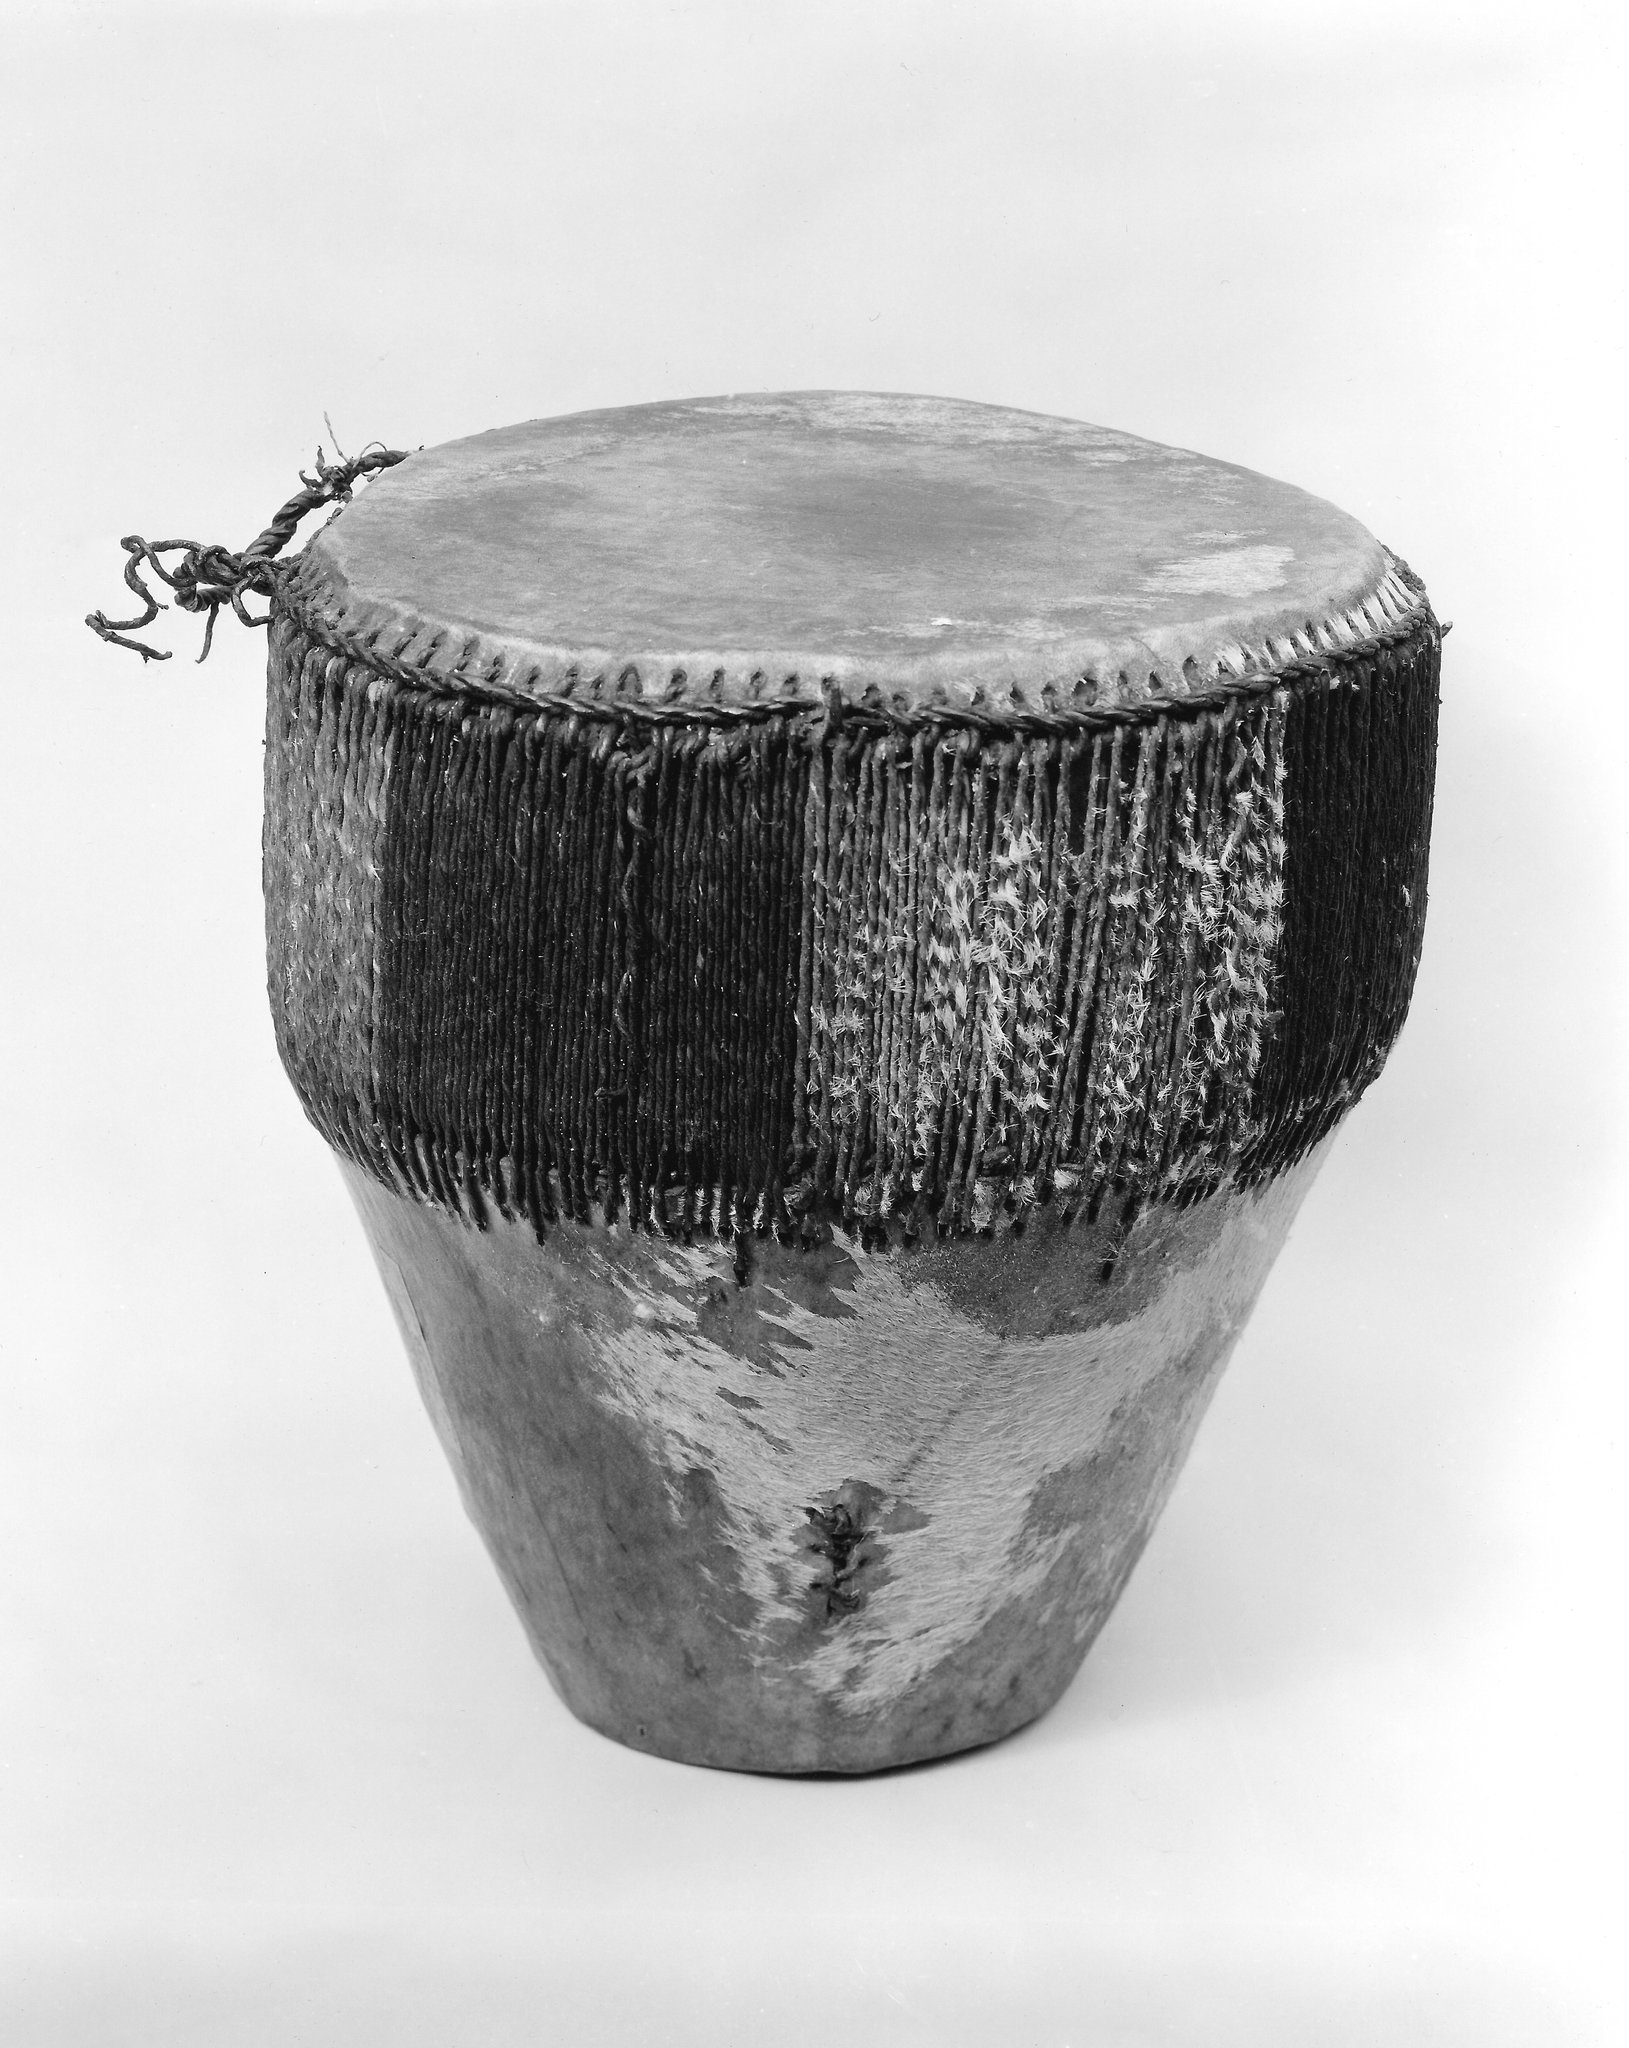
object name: embuutu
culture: ugandan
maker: ganda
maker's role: maker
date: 1801-1900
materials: wood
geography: uganda